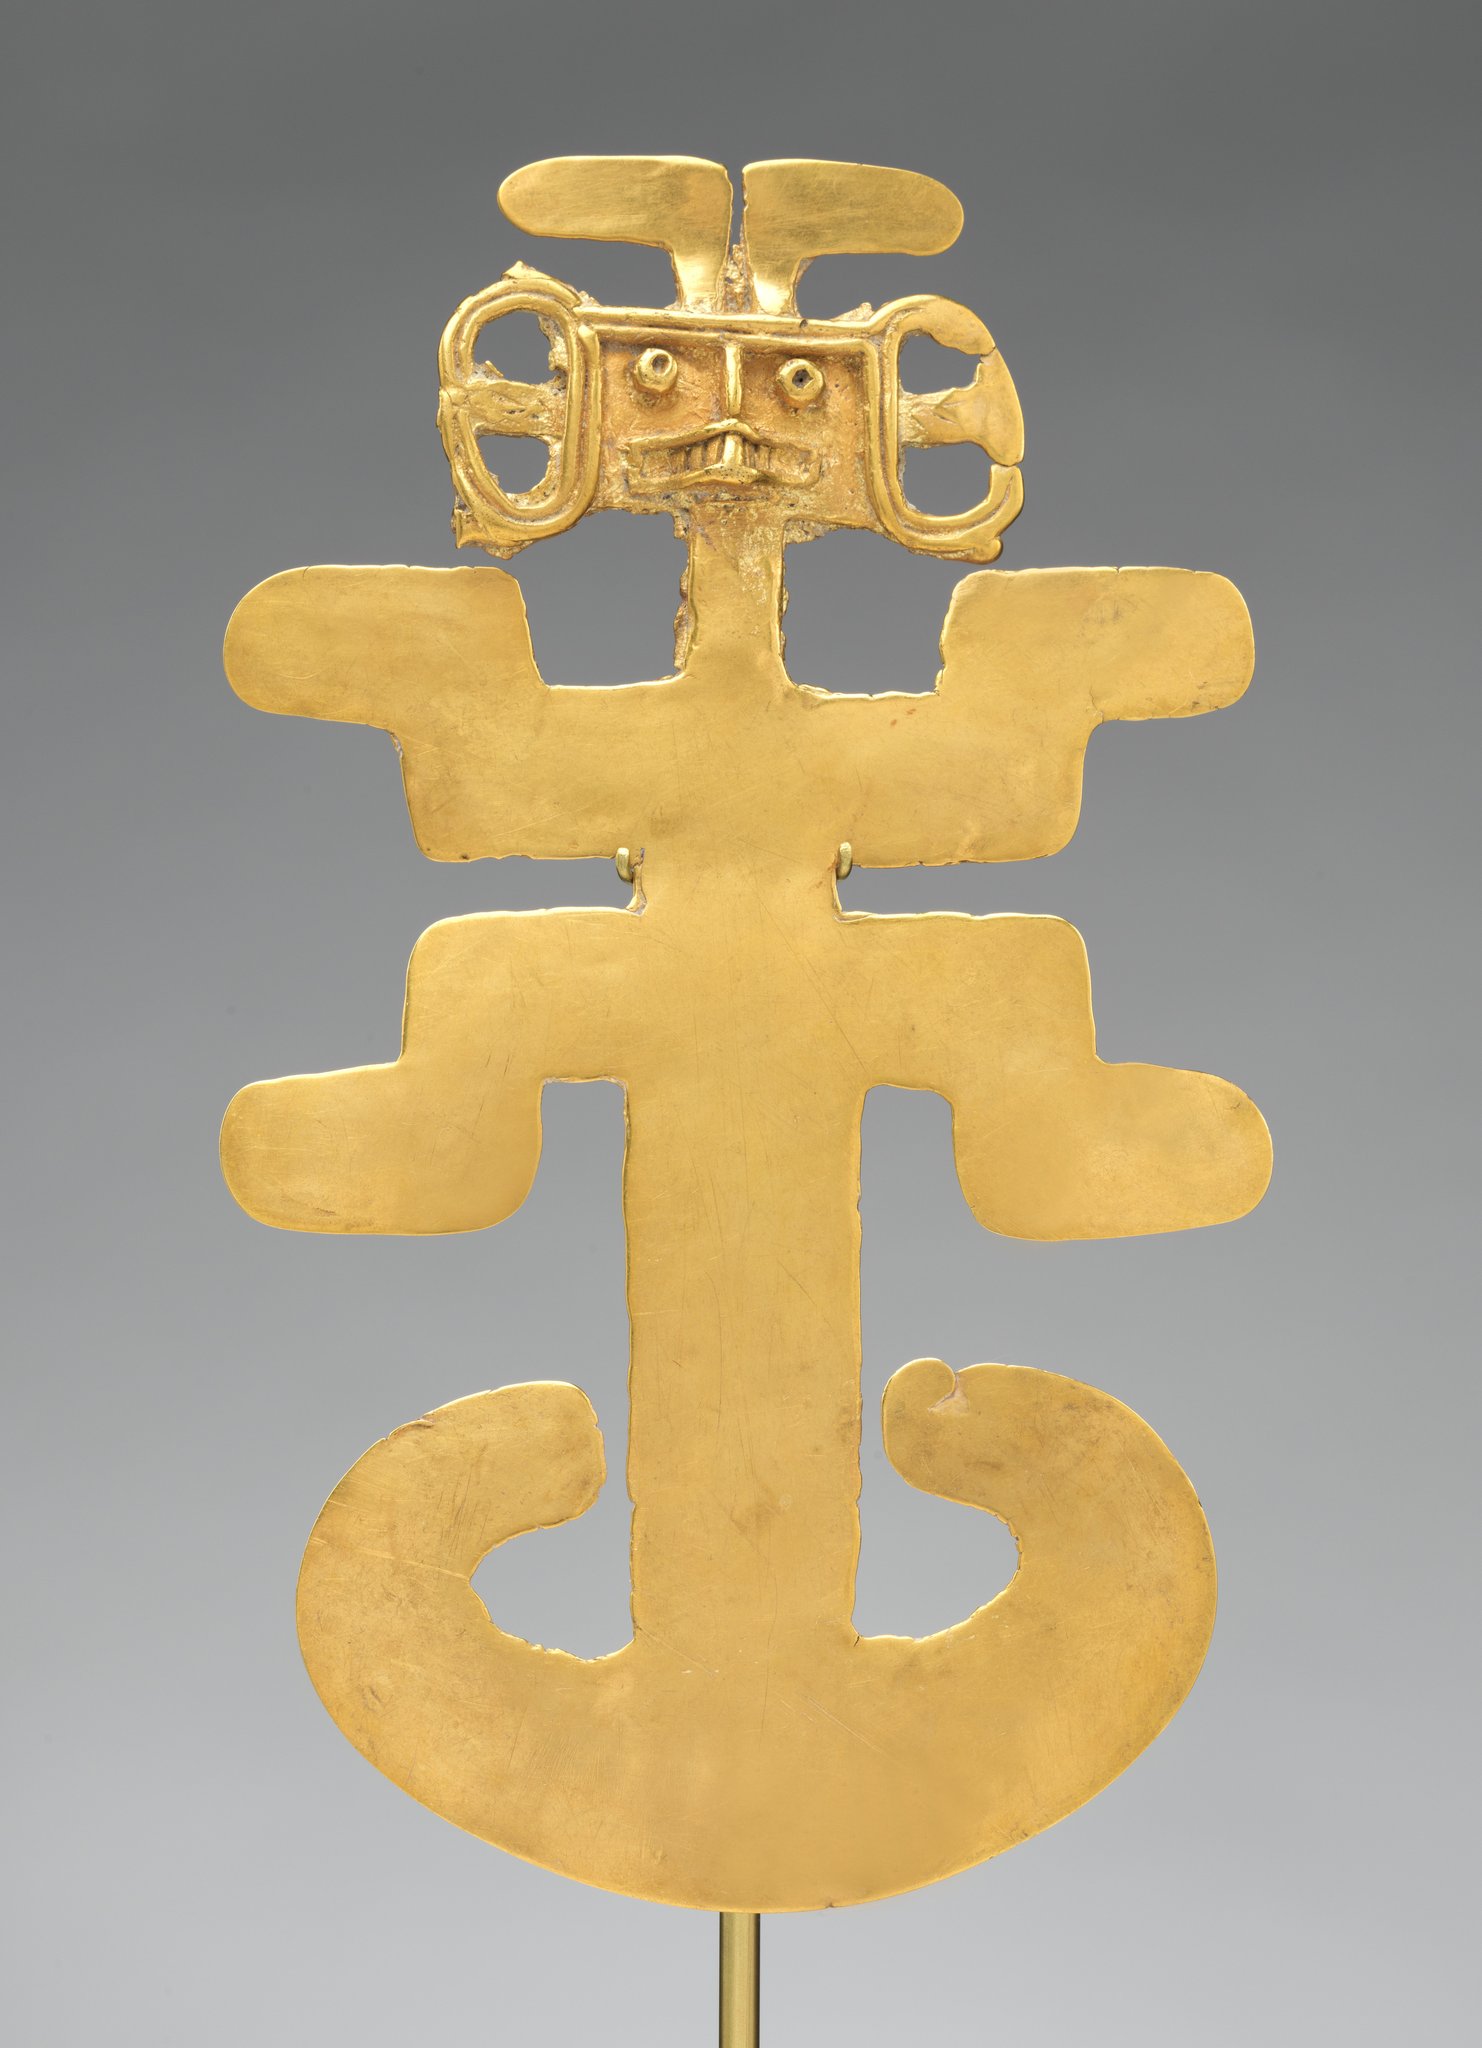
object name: pendant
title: Anthropomorphic Pendant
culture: tolima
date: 401-1000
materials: gold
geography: colombia